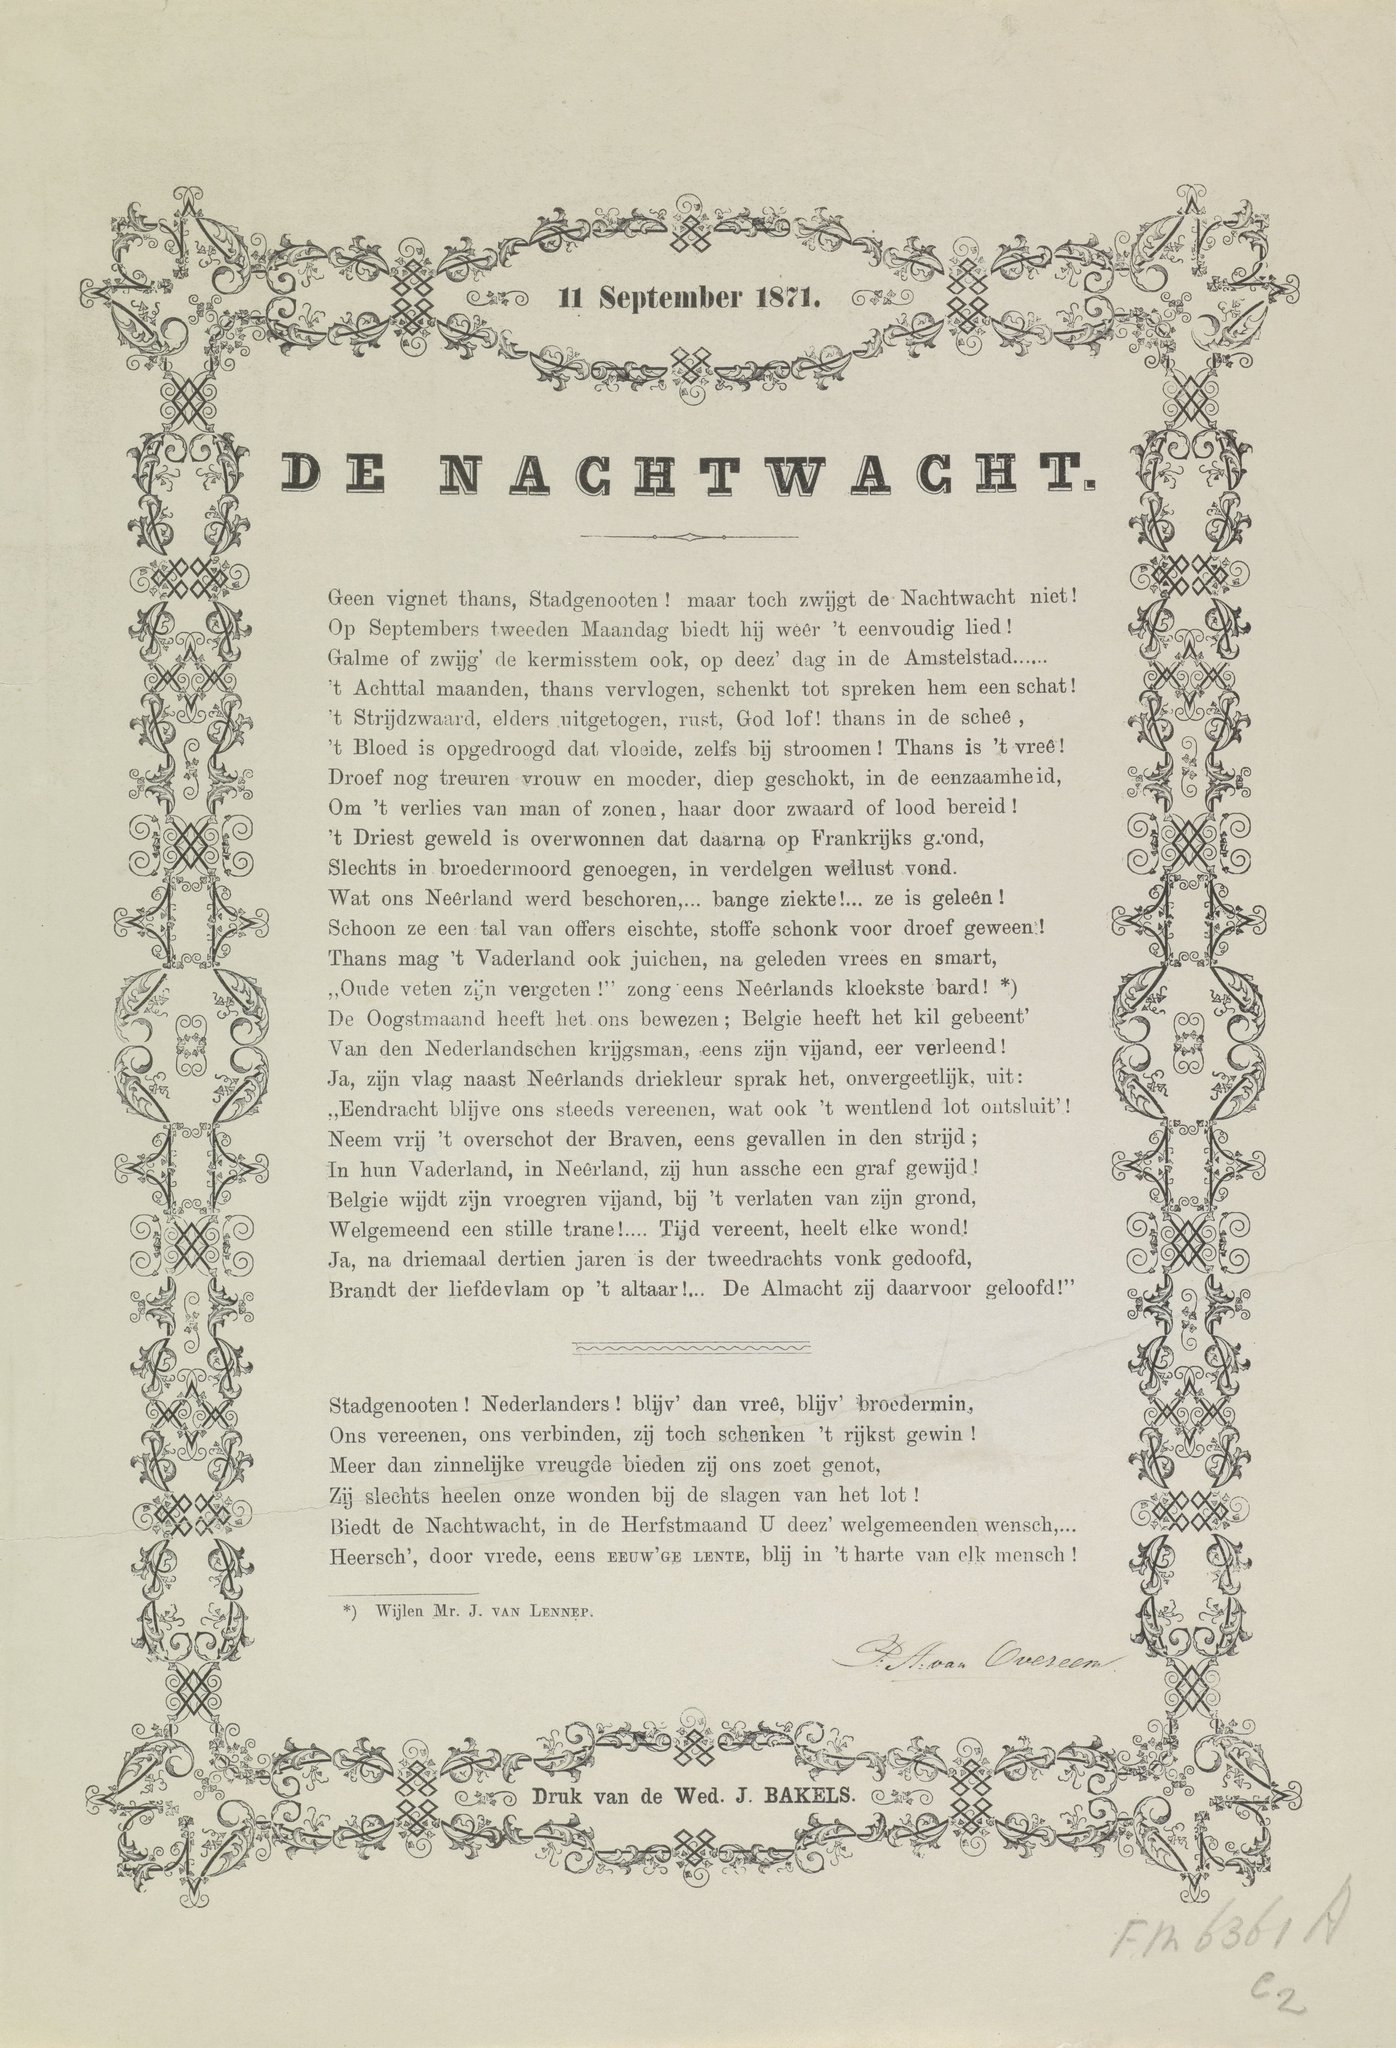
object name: print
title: De Nachtwacht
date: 1871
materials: paper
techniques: letterpress printing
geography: amsterdam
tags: night patrol, amsterdam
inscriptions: collector's mark: Lugt 2228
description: Kermisprent van de Amsterdamse nachtwacht, 11 september 1871. Gedicht binnen ornamentele omlijsting.